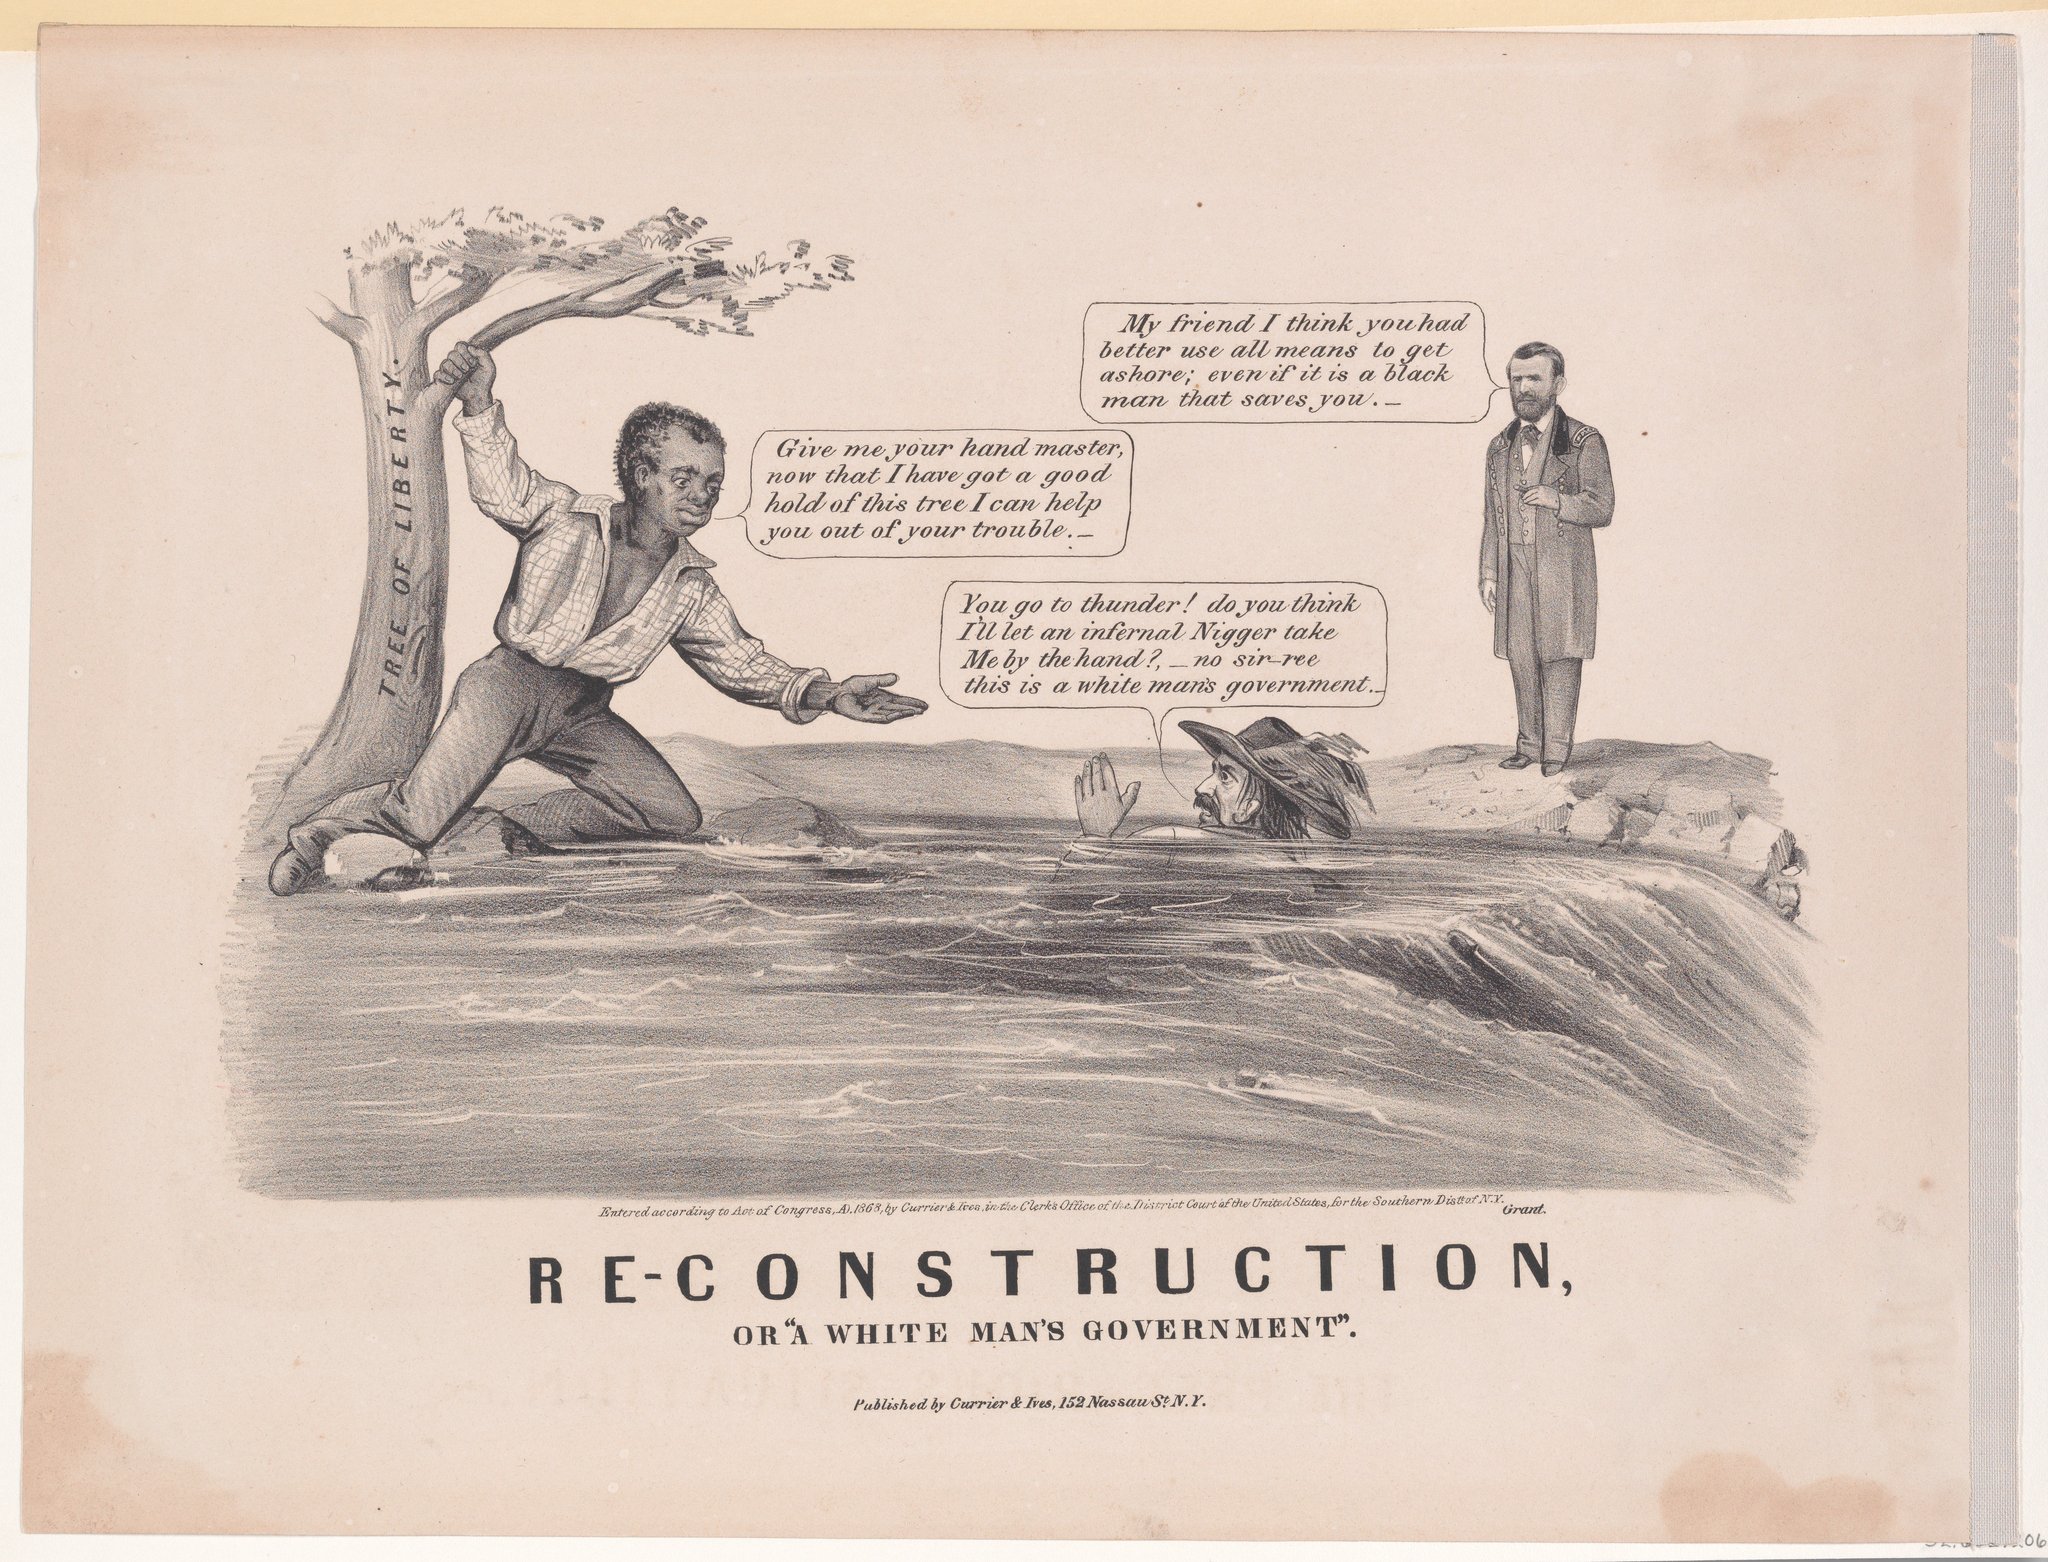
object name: print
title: Re-Construction, or "A White Man's Govenment"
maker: currier & ives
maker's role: publisher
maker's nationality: american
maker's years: 1857-1907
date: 1868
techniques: lithograph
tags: satire,politics